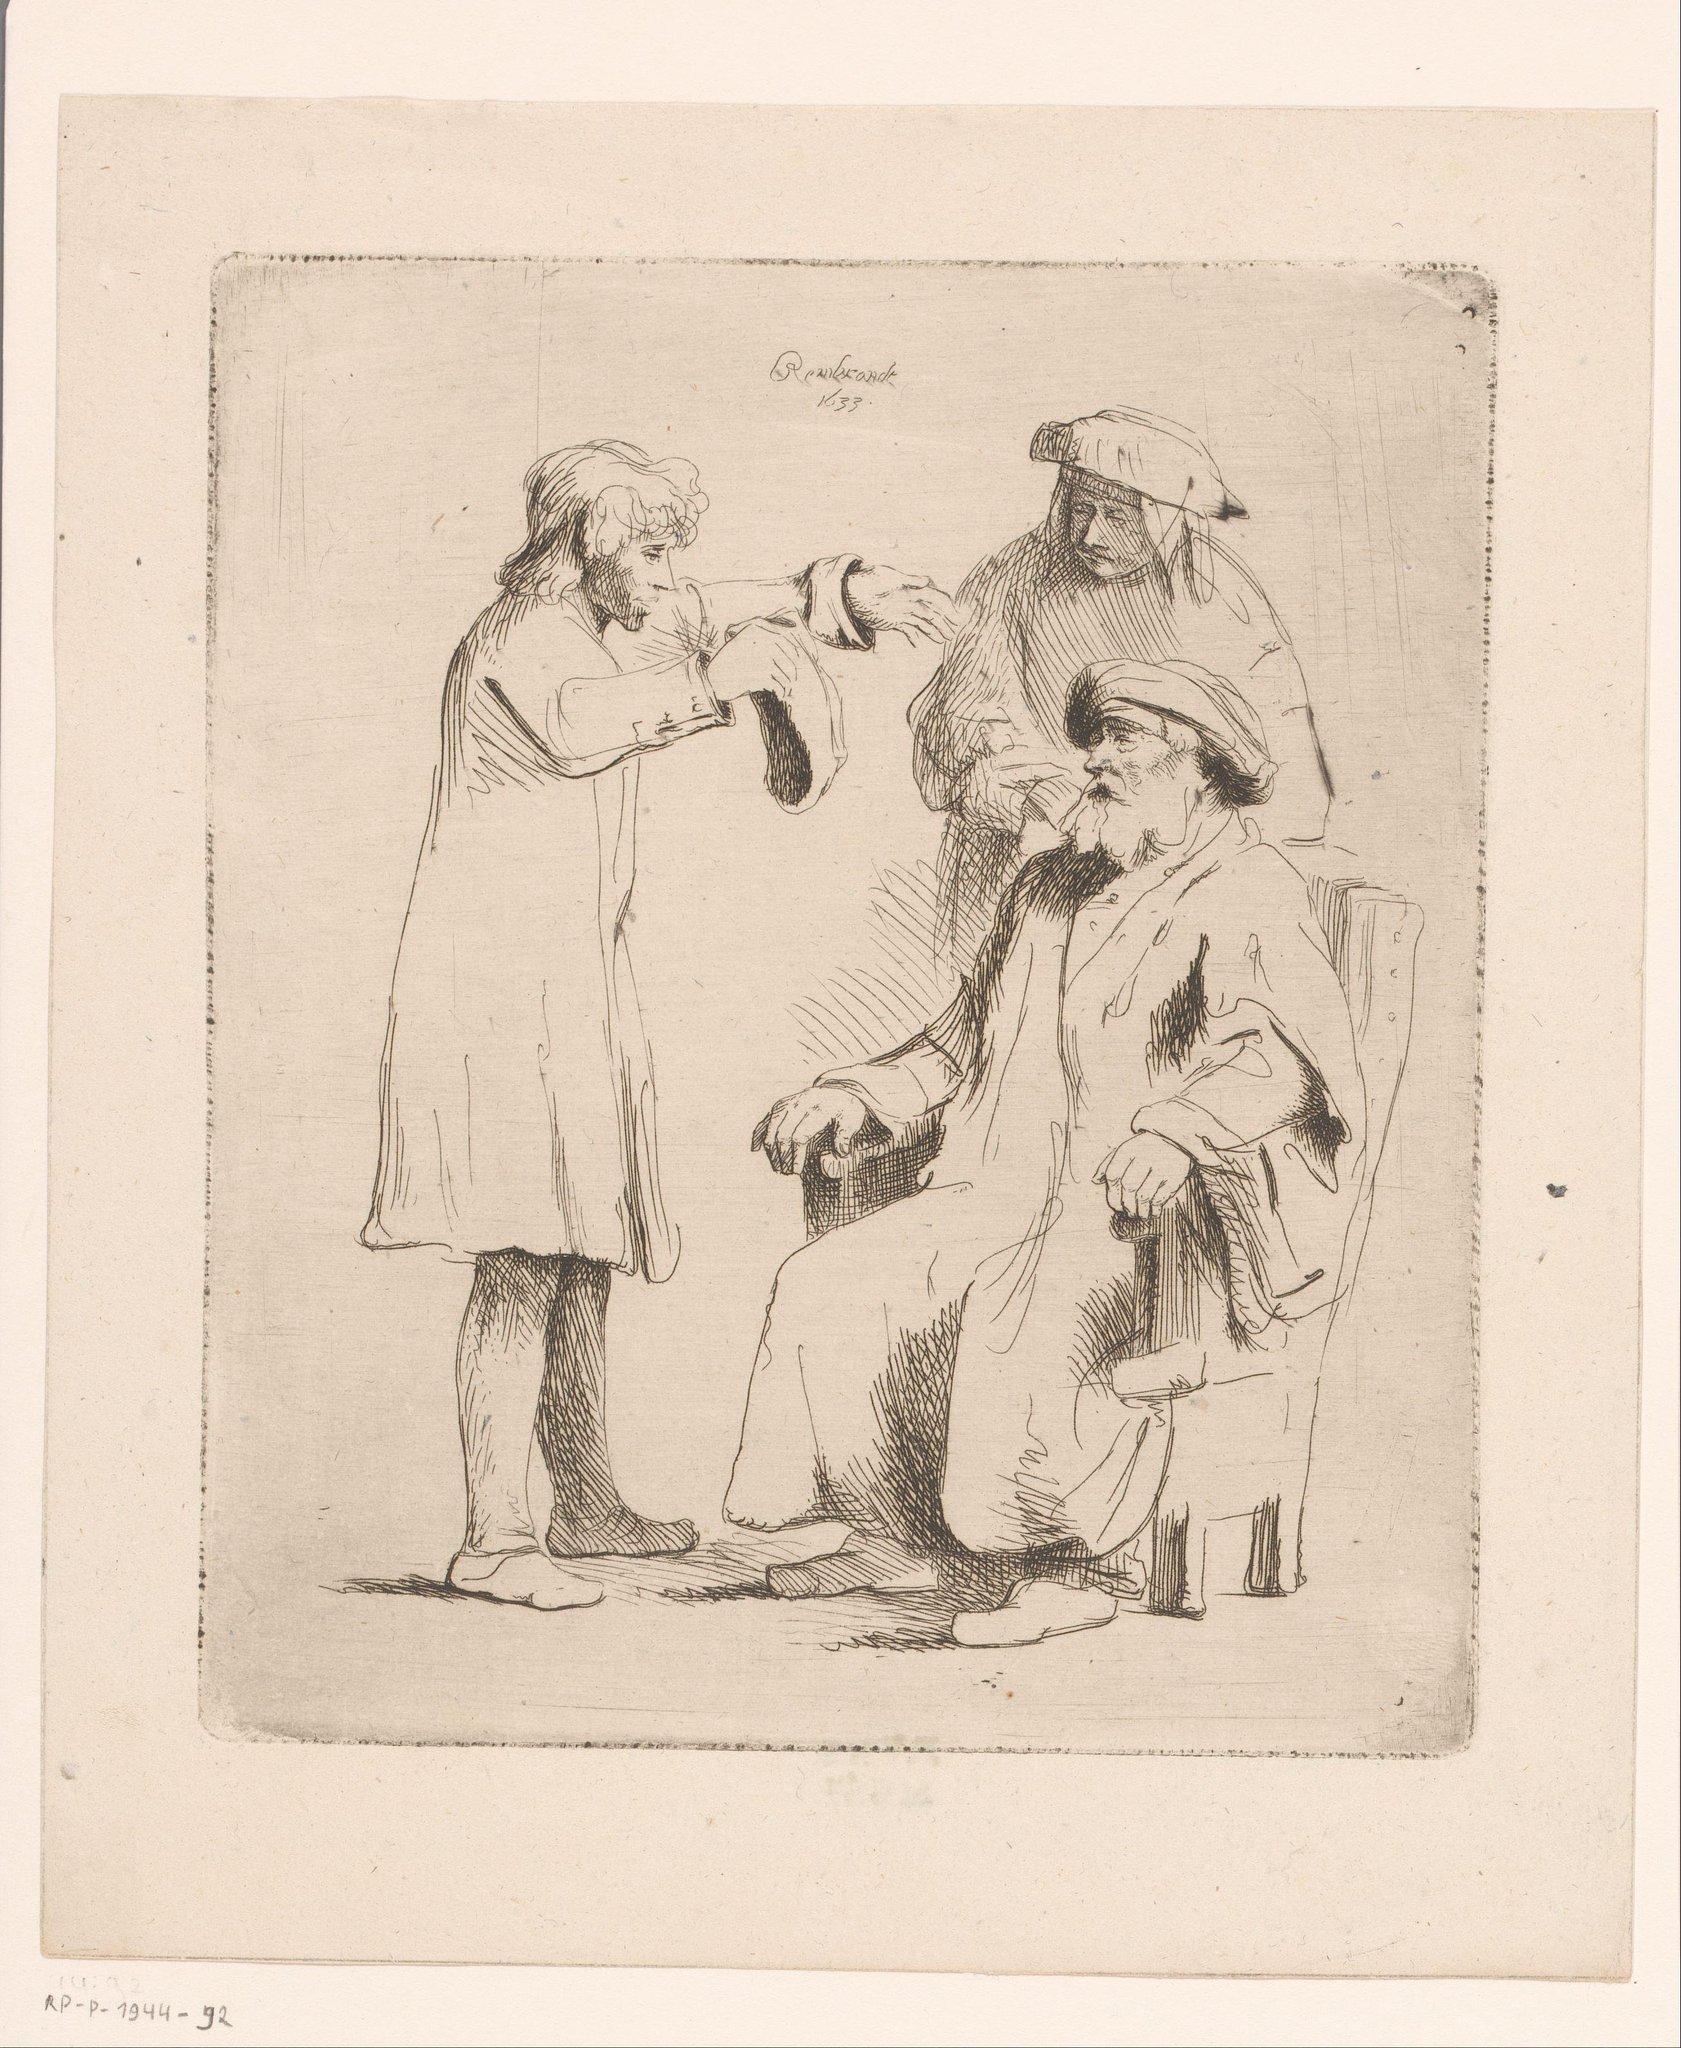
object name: print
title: Jonge man bij oude man in stoel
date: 1805-1844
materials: paper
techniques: drypoint, etching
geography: france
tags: sitting figure, youth, adolescent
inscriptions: collector's mark: Lugt 2165